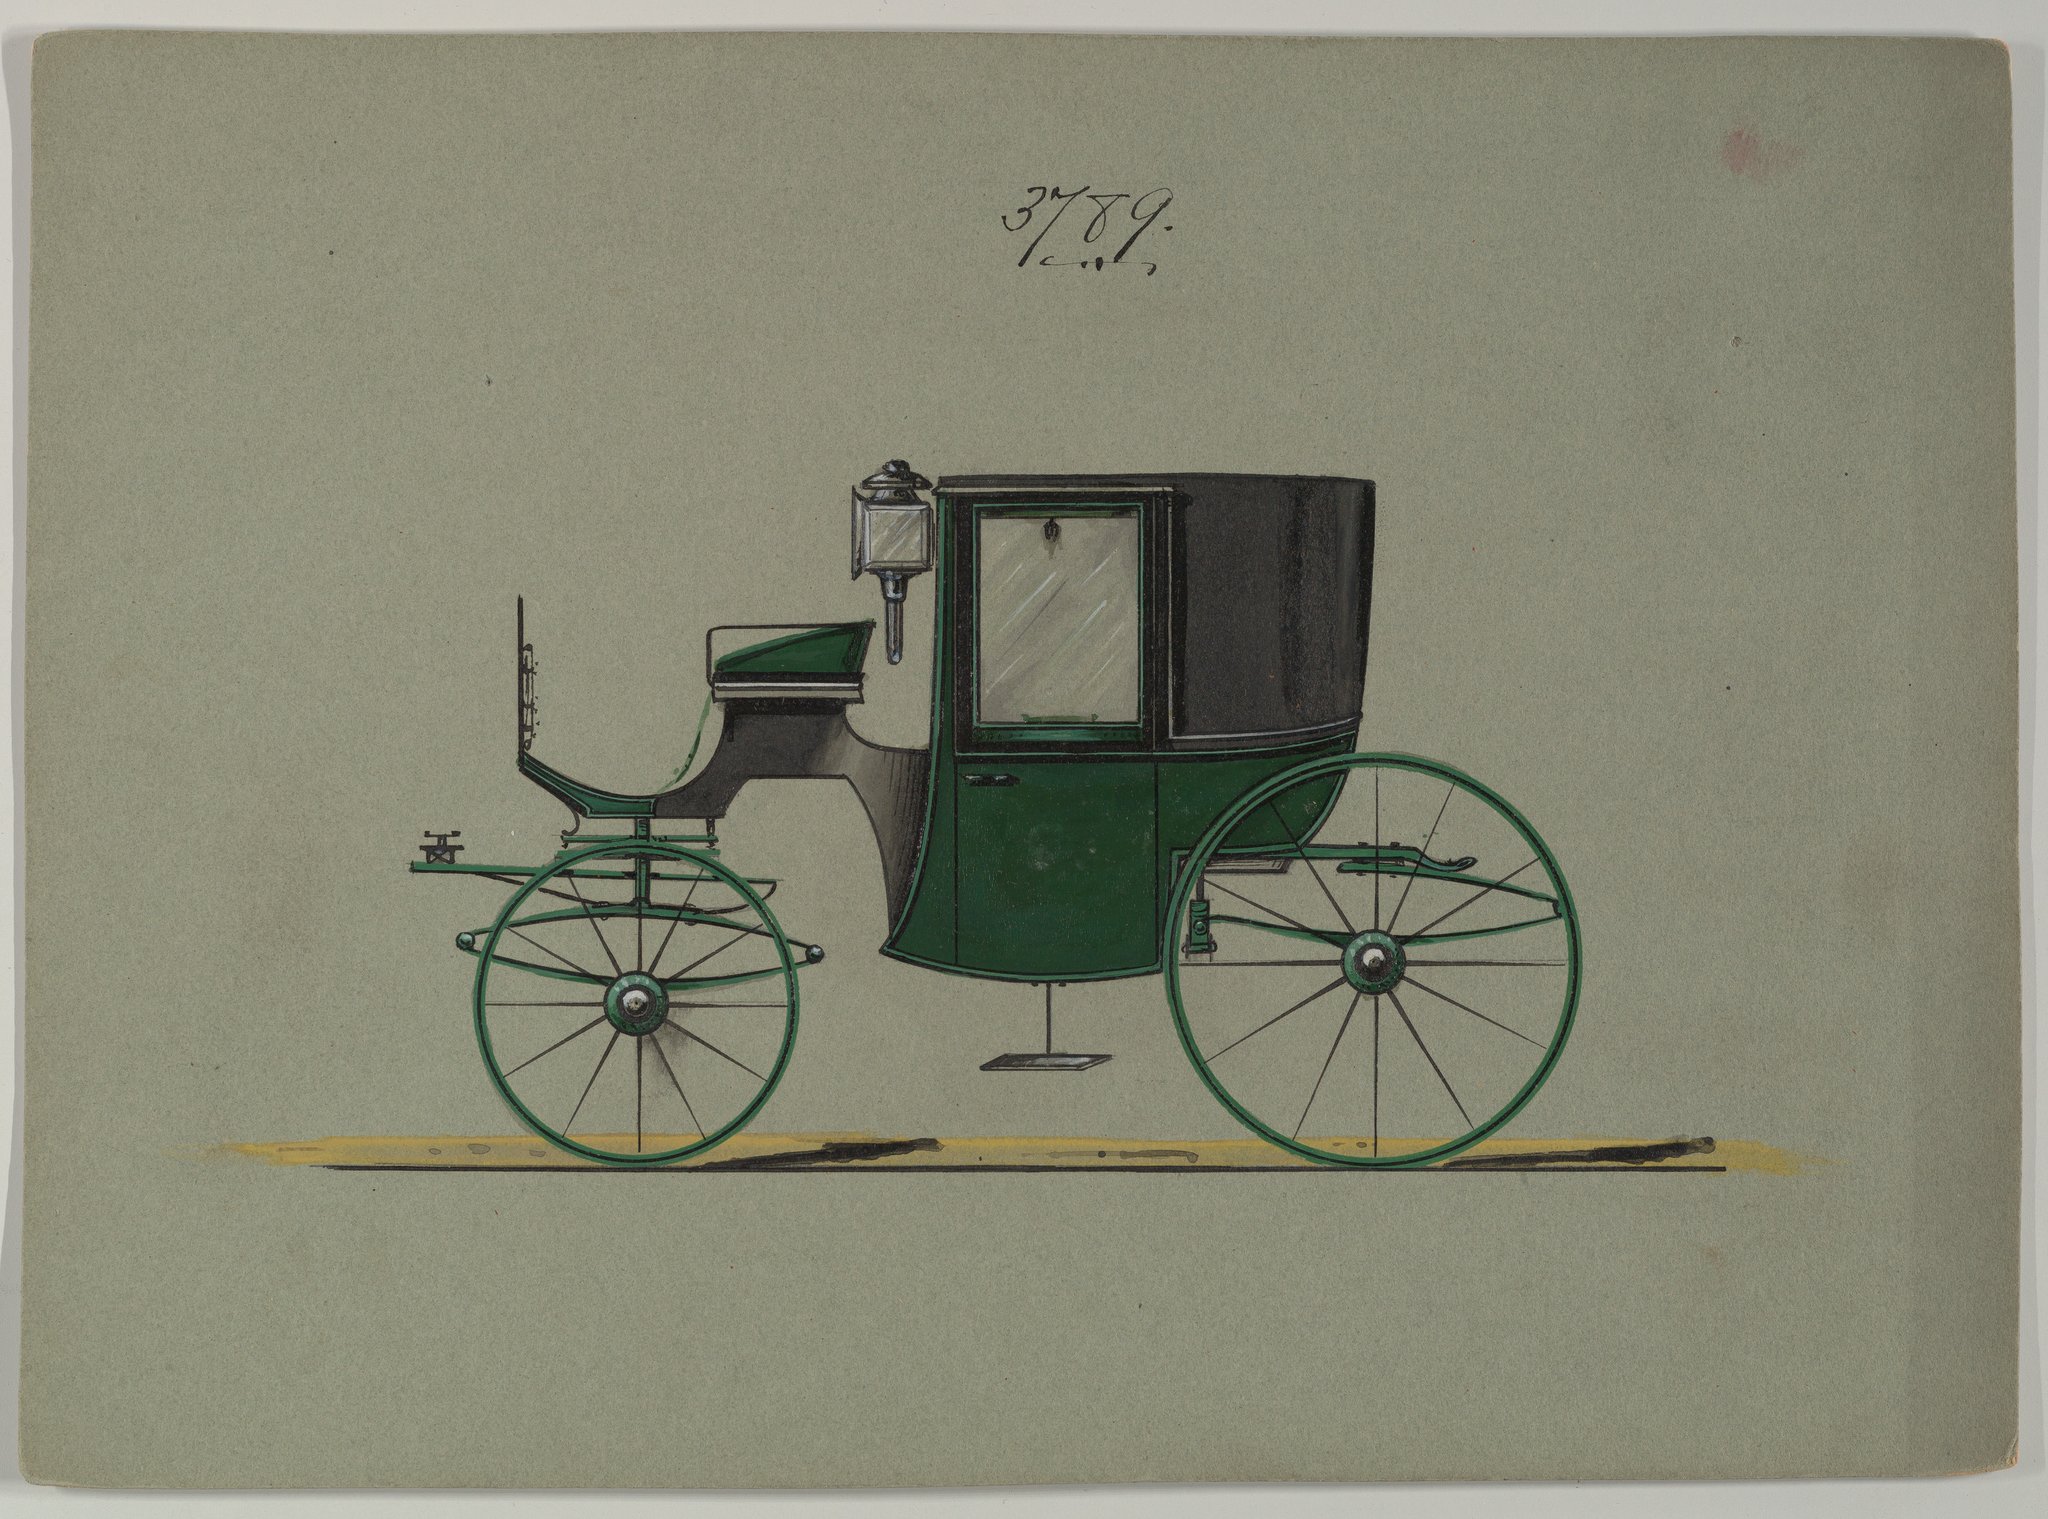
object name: drawing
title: Brougham #3789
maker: brewster & co.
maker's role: manufacturer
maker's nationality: american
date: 1882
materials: gouache, gum arabic, ink, watercolor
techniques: pen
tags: carriages